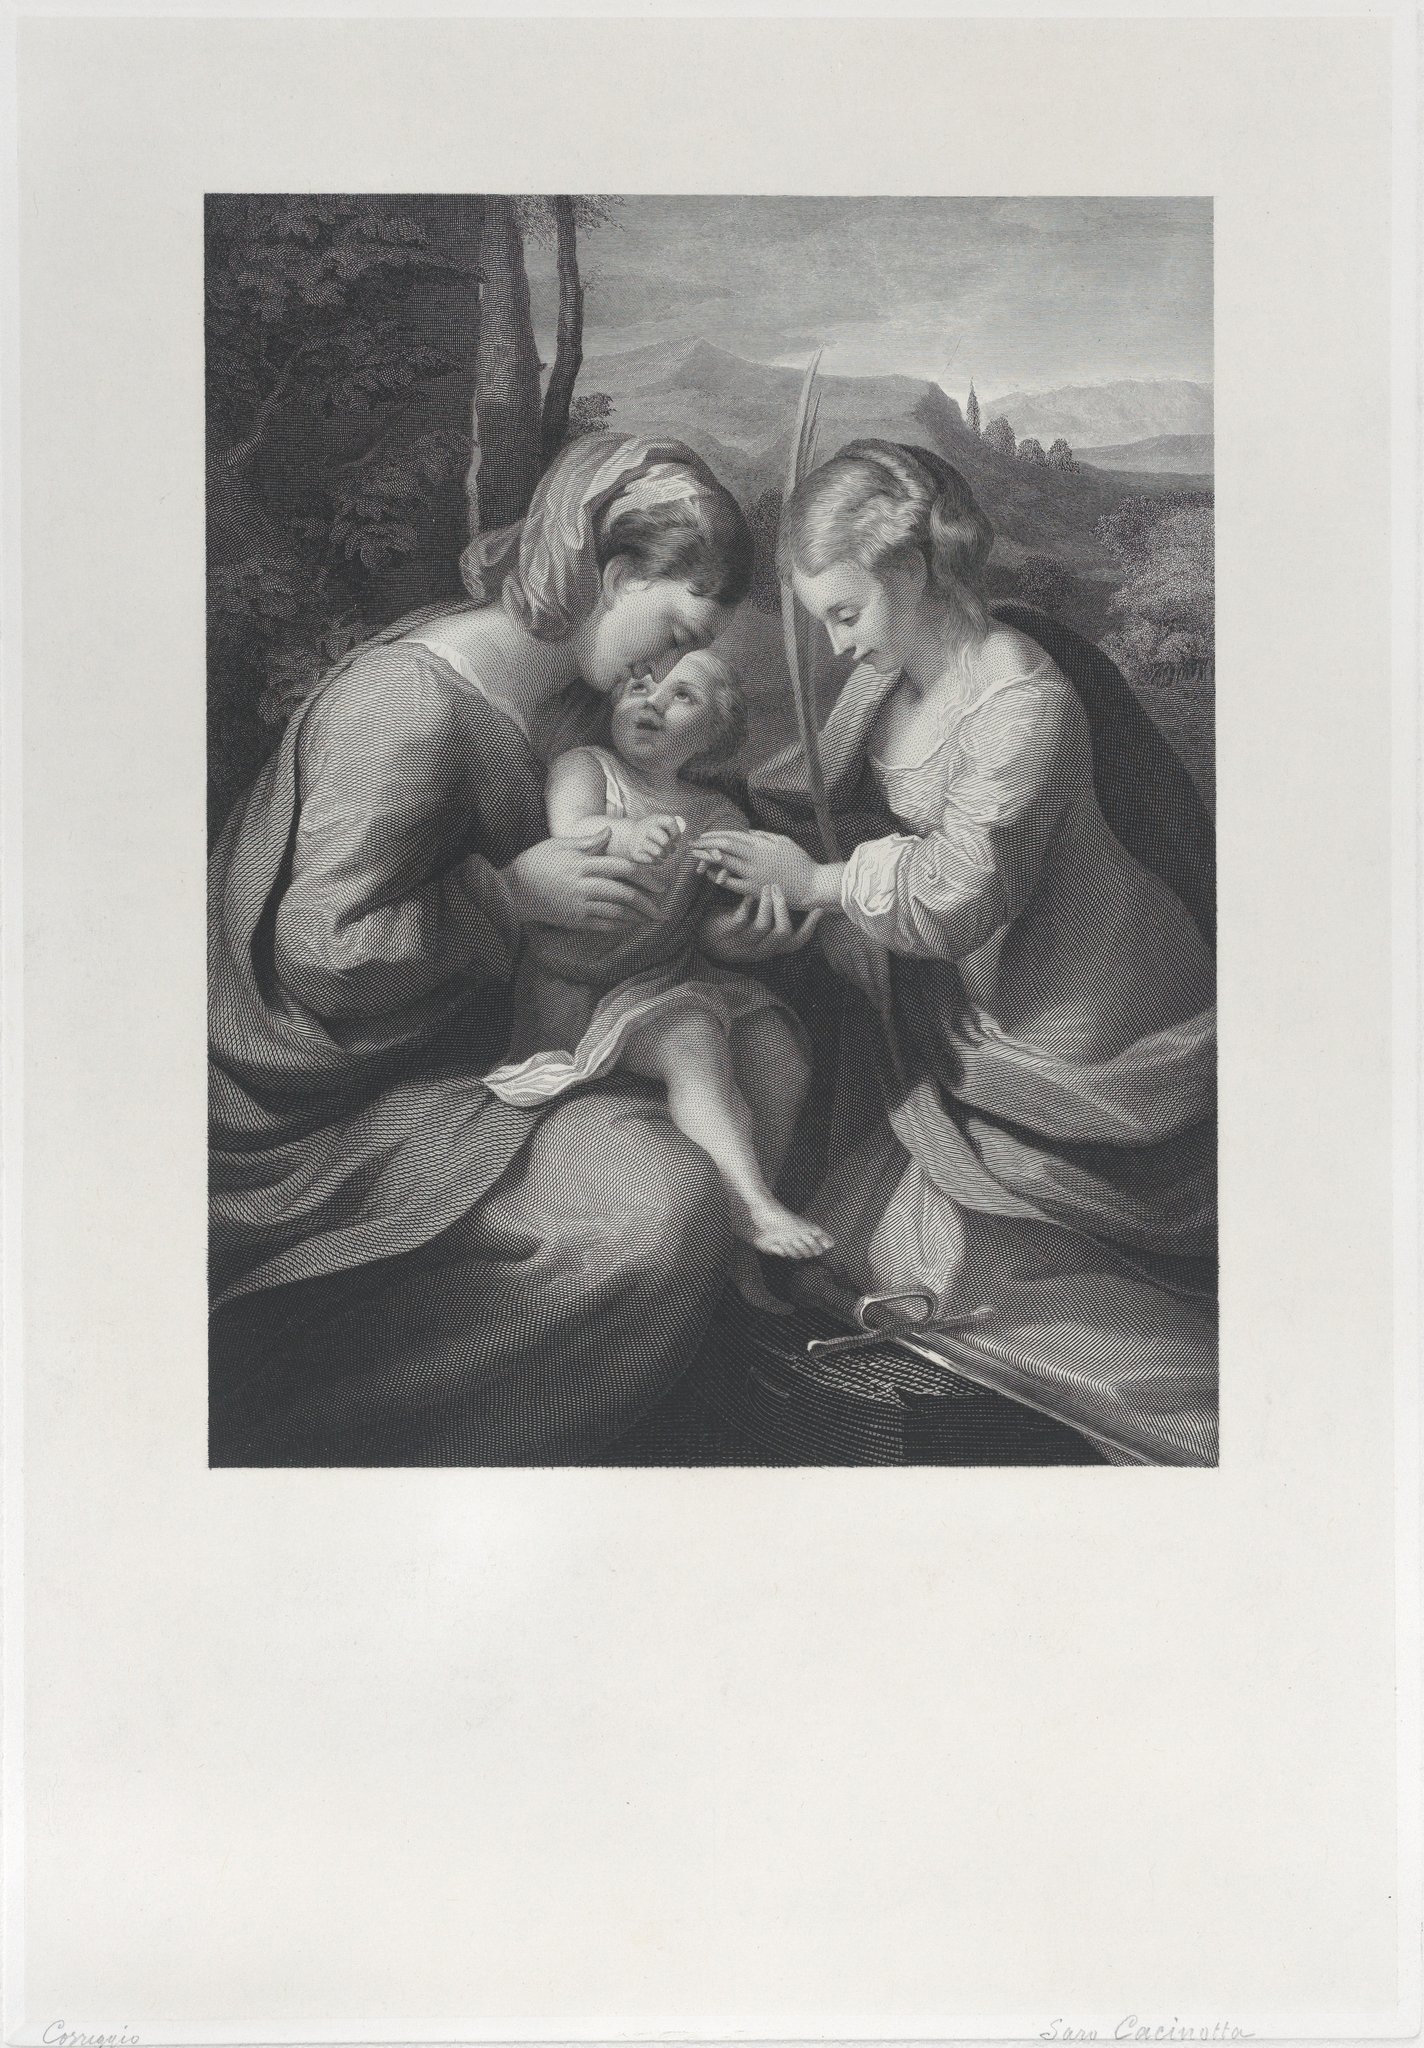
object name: print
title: The mystic marriage of Saint Catherine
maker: georg jacob felsing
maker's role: artist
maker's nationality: german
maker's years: 1802-1883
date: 1831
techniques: engraving